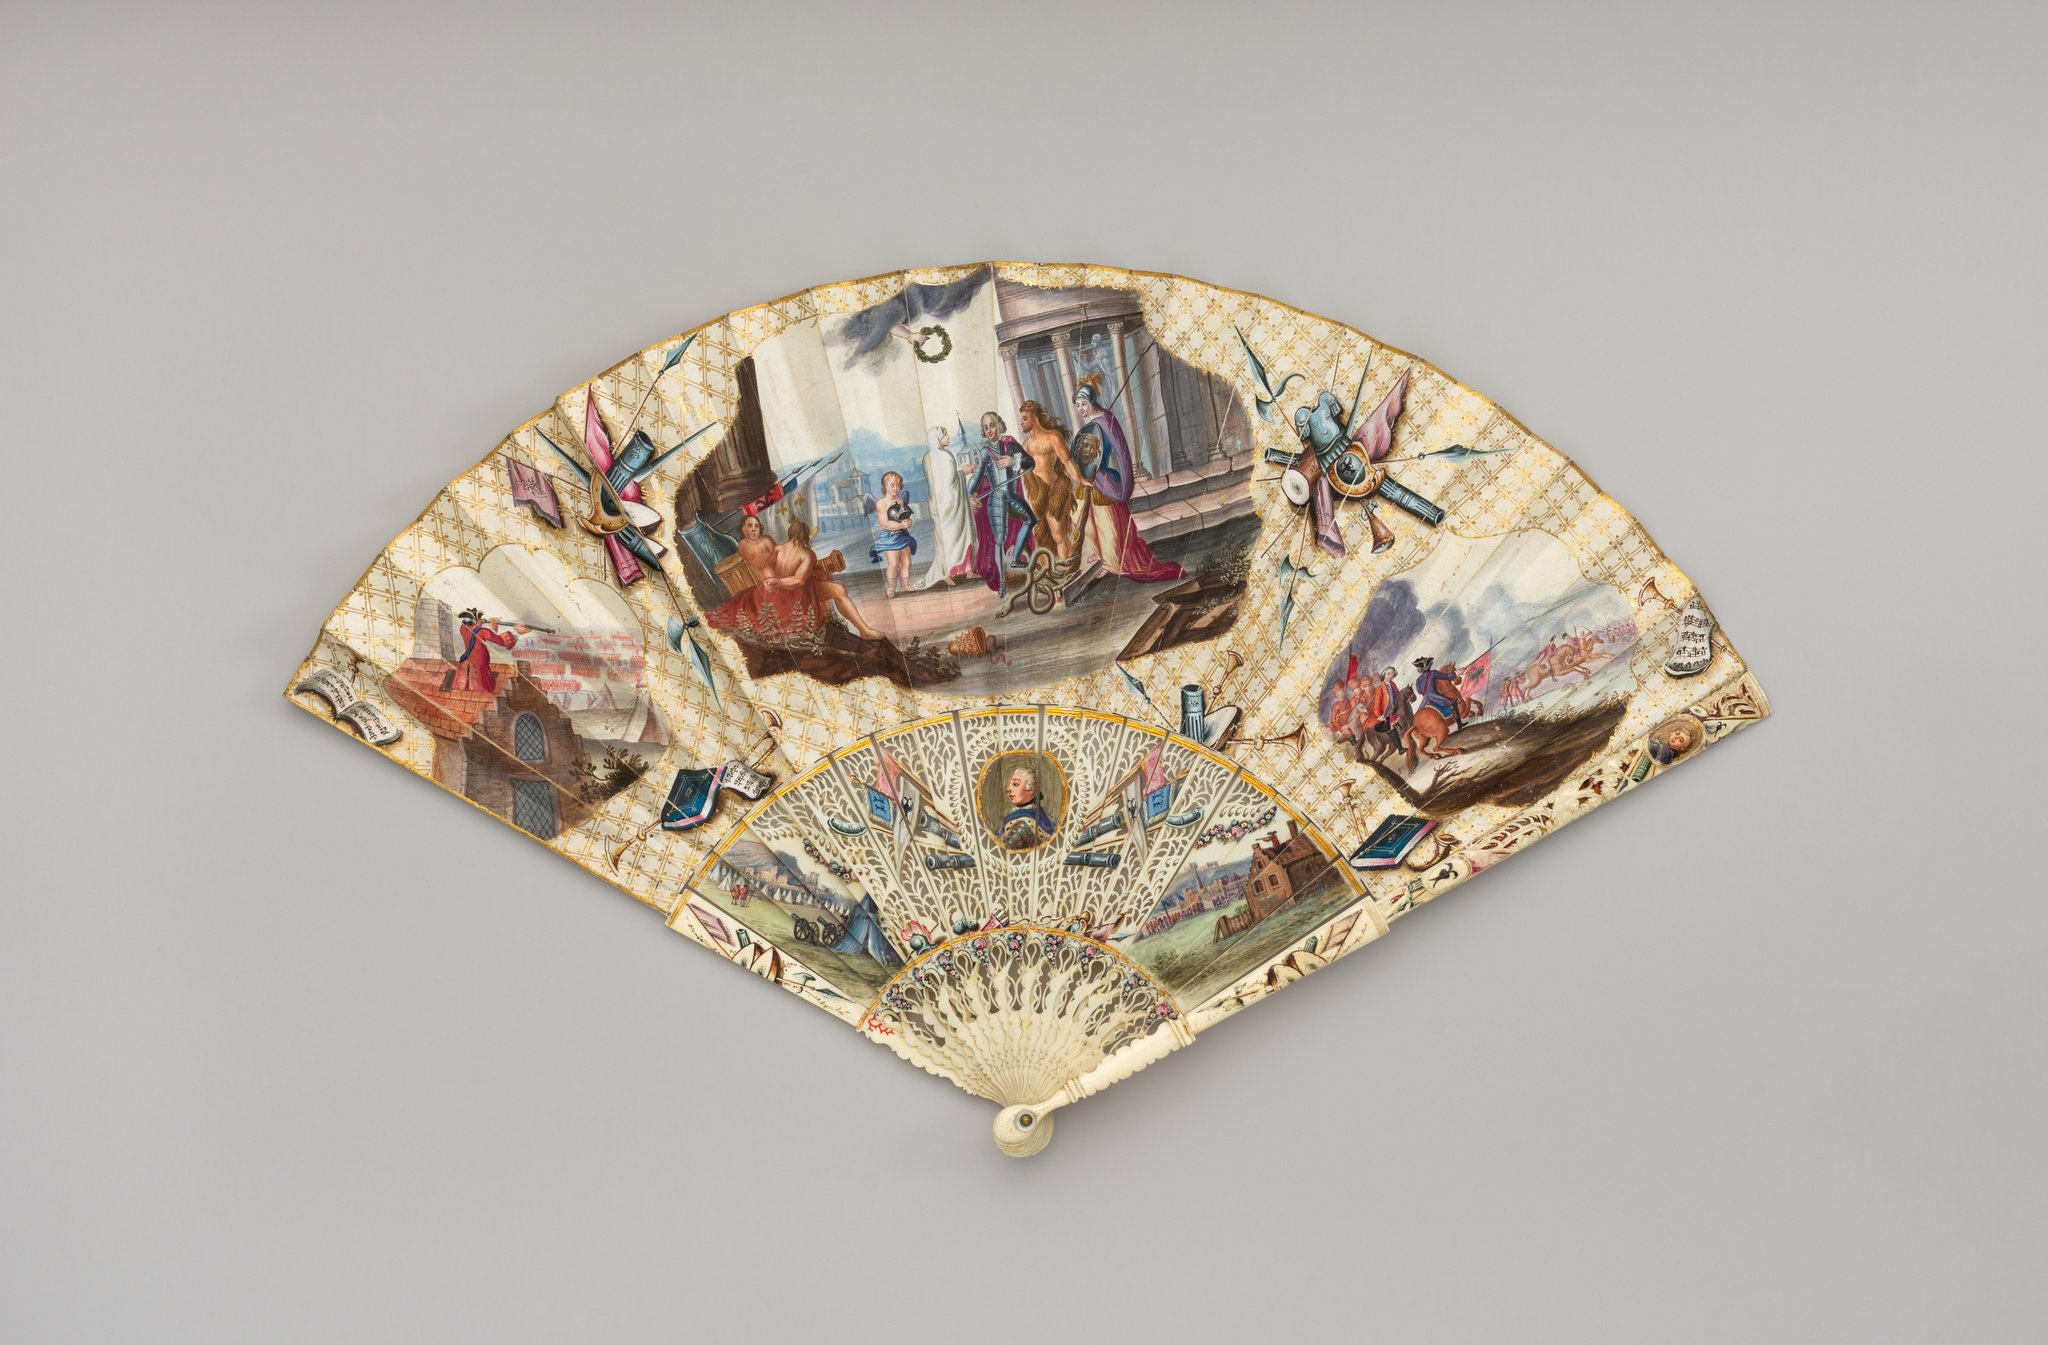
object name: fan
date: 1701-1800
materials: ivory, mother of pearl, parchment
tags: men,women,horses